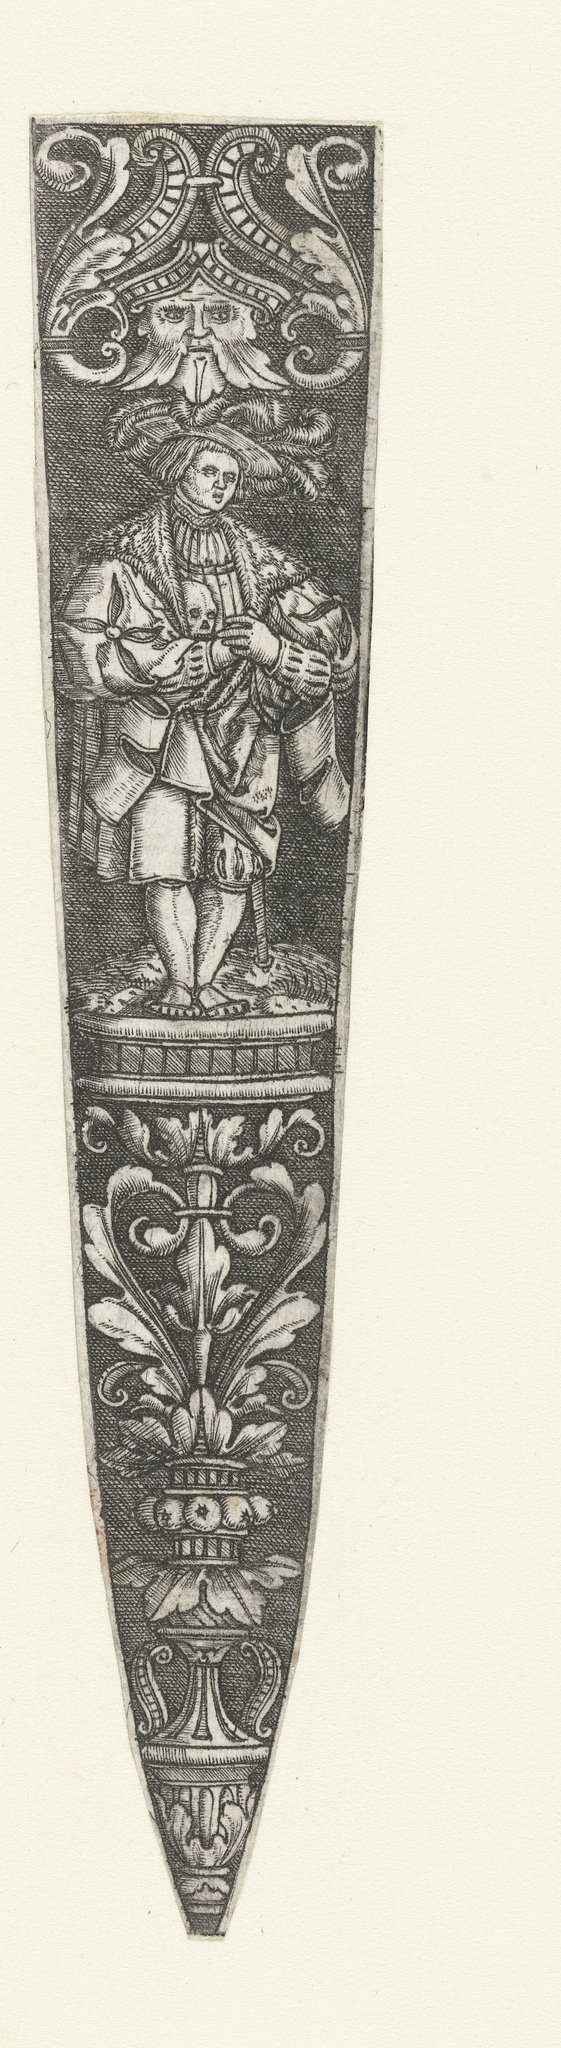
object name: print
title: Decoratie van de schede van een dolk met mascaron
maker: Anonymous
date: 1500-1600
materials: paper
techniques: engraving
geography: netherlands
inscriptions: collector's mark: Lugt 240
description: Bovenaan hangt een mascaron boven een man met een schedel onder zijn jas. Gearceerde achtergrond.